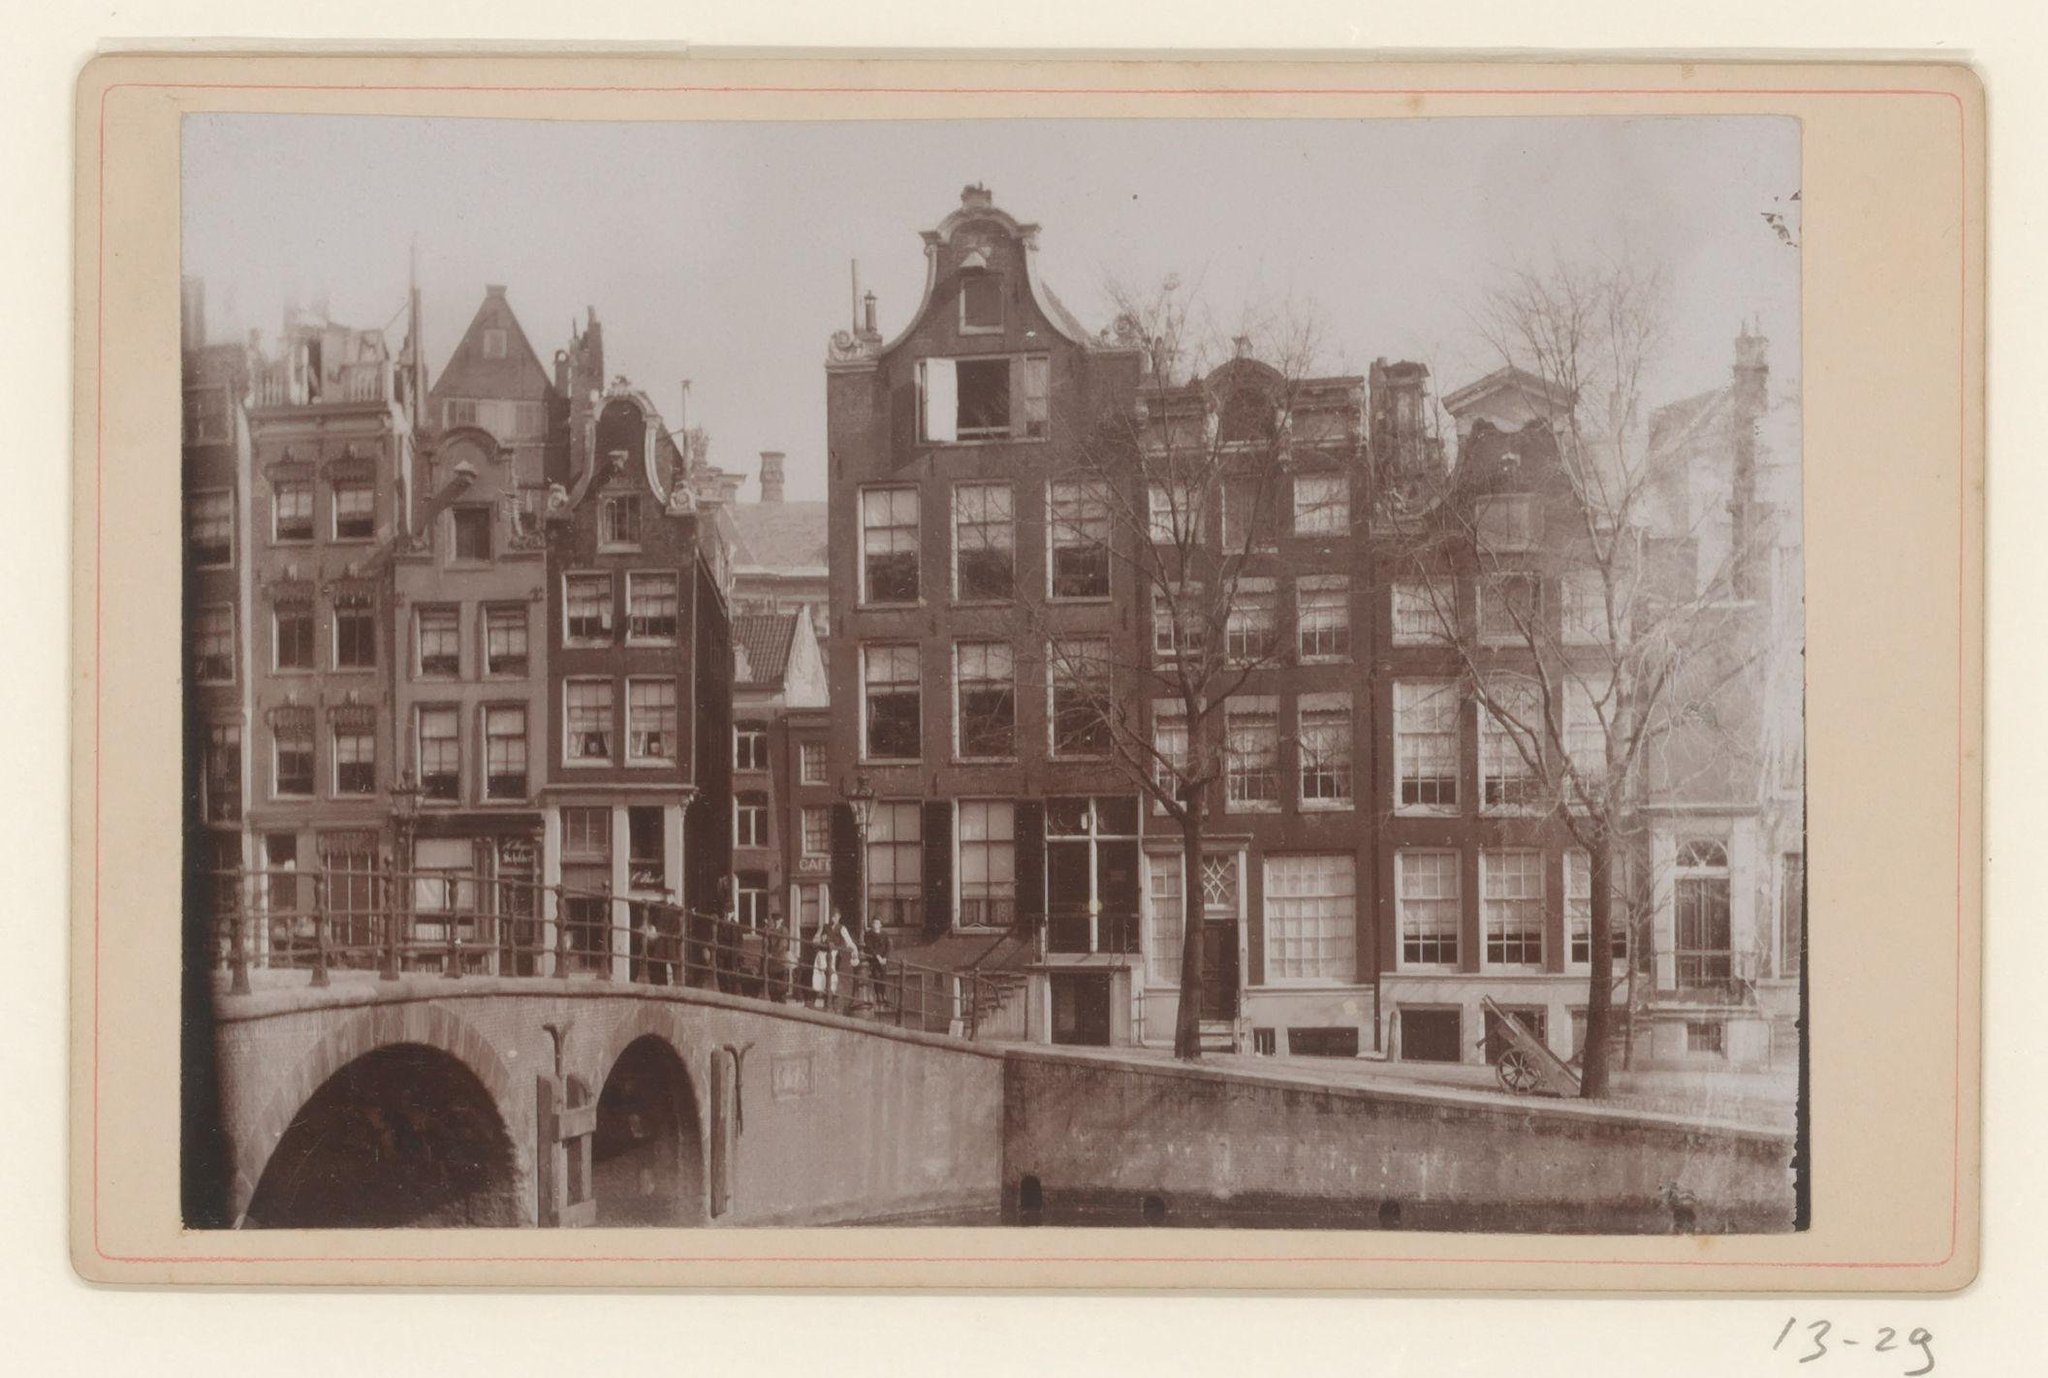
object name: cabinet photograph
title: Gezicht op de Singel bij de Huiszittenbrug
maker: Anonymous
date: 1875-1896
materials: paper, cardboard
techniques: collodion silver print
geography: amsterdam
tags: city-view in general; 'veduta', canal, the usual house or row of houses, bridge in city across river, canal, etc.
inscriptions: stamp: ‘Gebr. Douwes / Atelier / Grimburgwal 15 / Amsterdam’, collector's mark: ‘13,29’ Lugt 1641b, inscription: ‘94. / Singel b/d Huiszittens brug v/d afbraak.’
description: Onderwerpsrubriek binnen de Atlas Amsterdam: Oude Schans, Schoutensteeg, Singel (Korte), Singel.